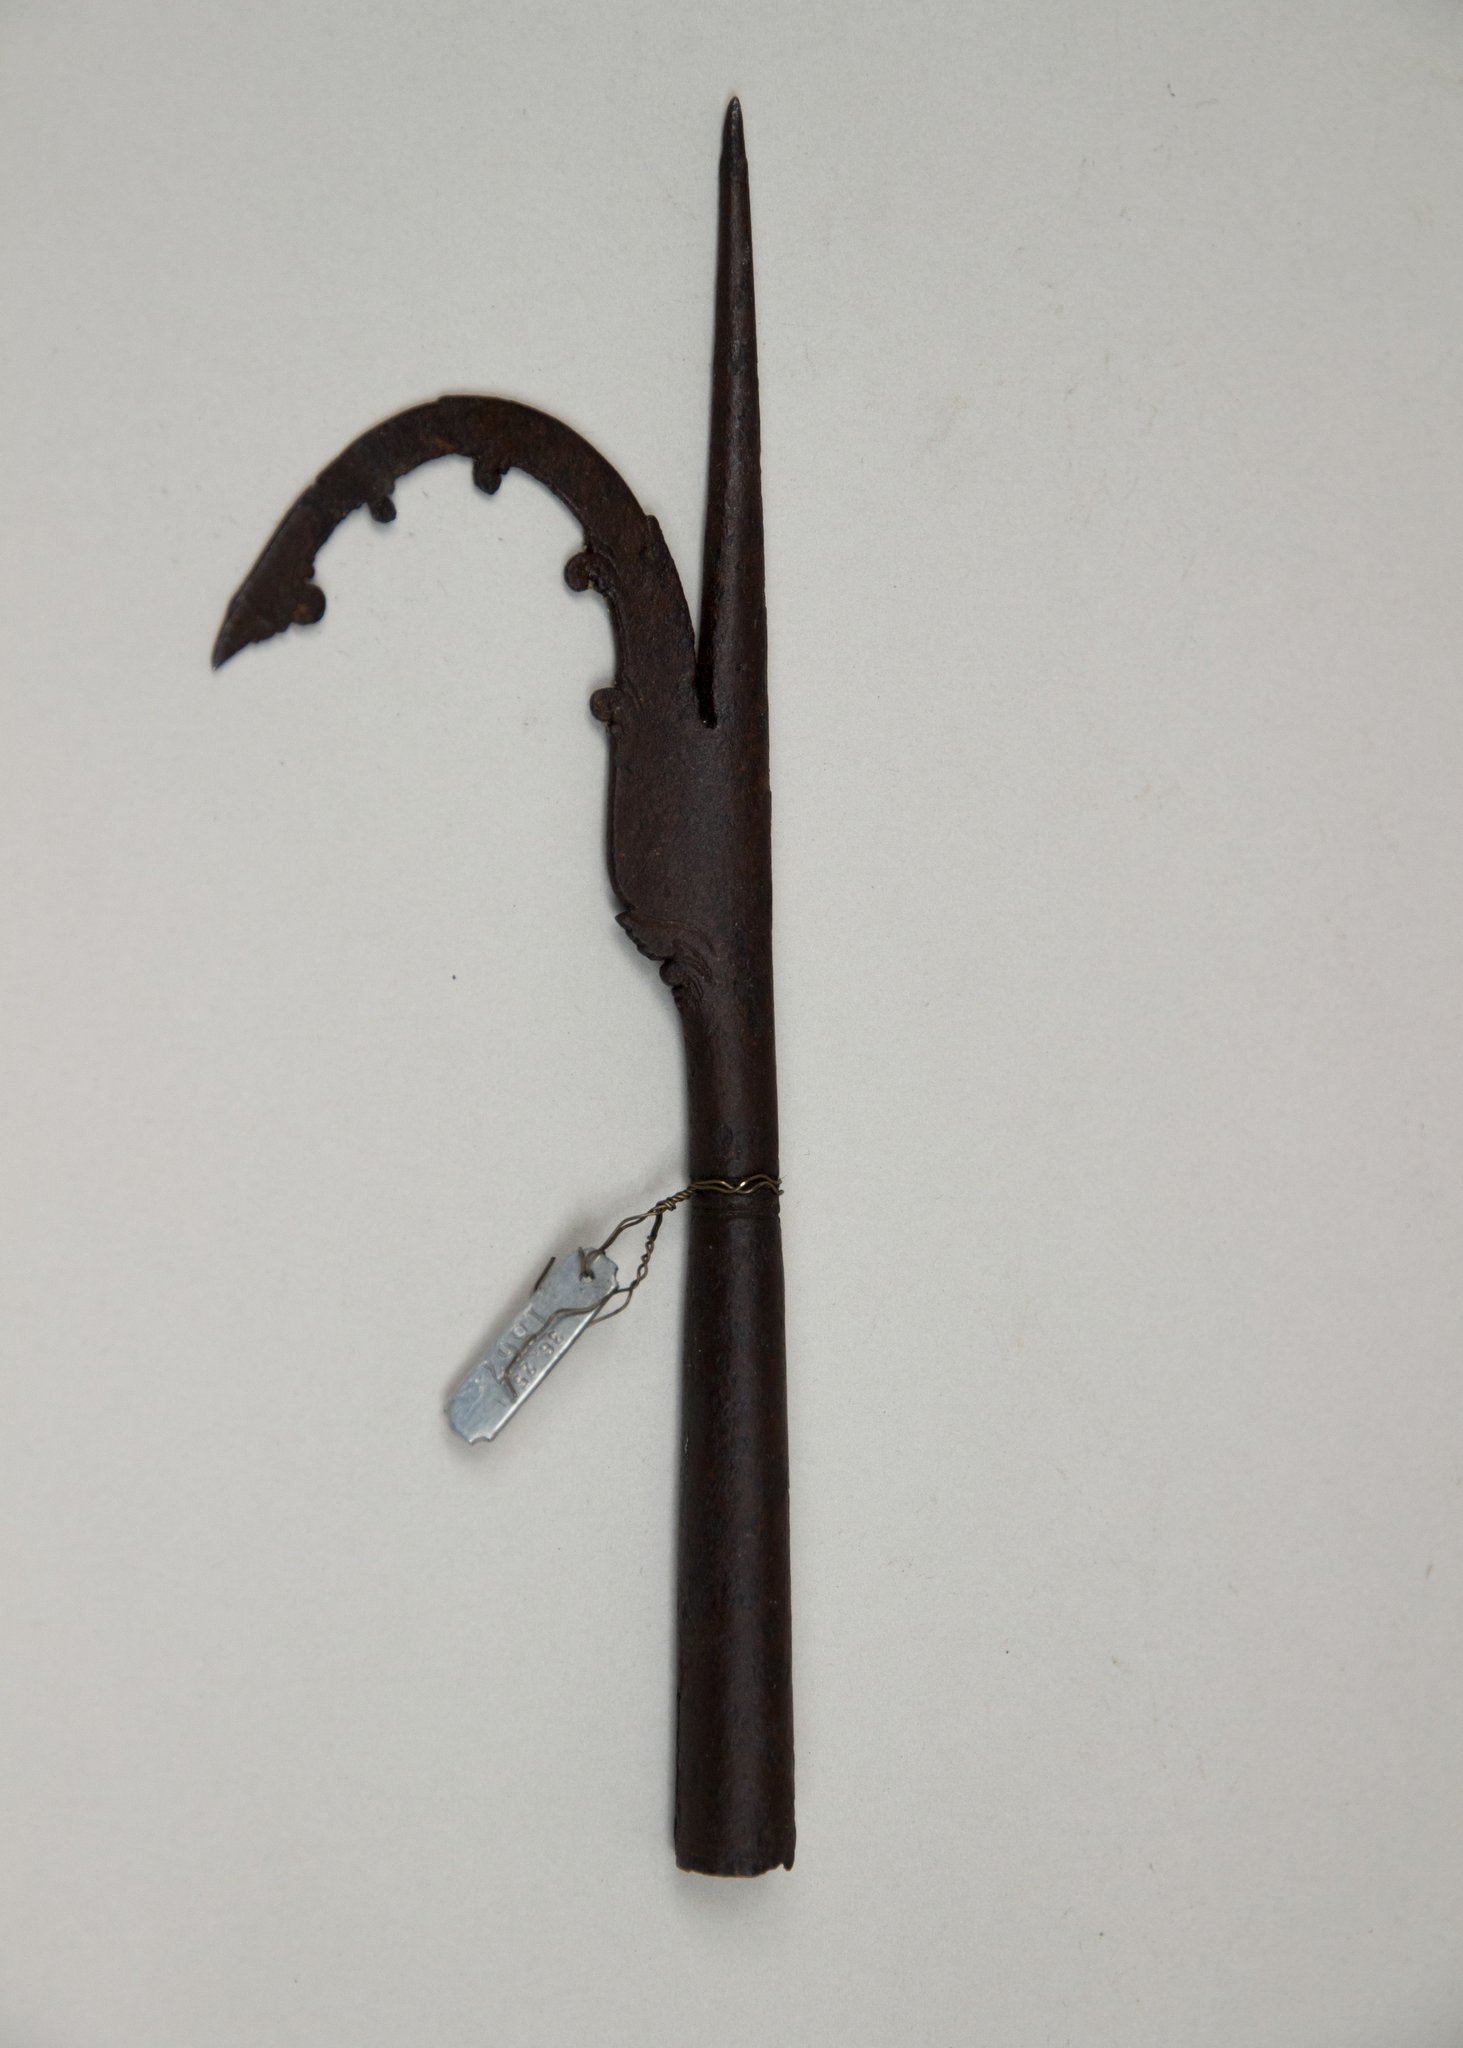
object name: blade for a spear su yari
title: Blade for a Spear (Su-yari)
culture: japanese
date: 1501-1600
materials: steel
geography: japan